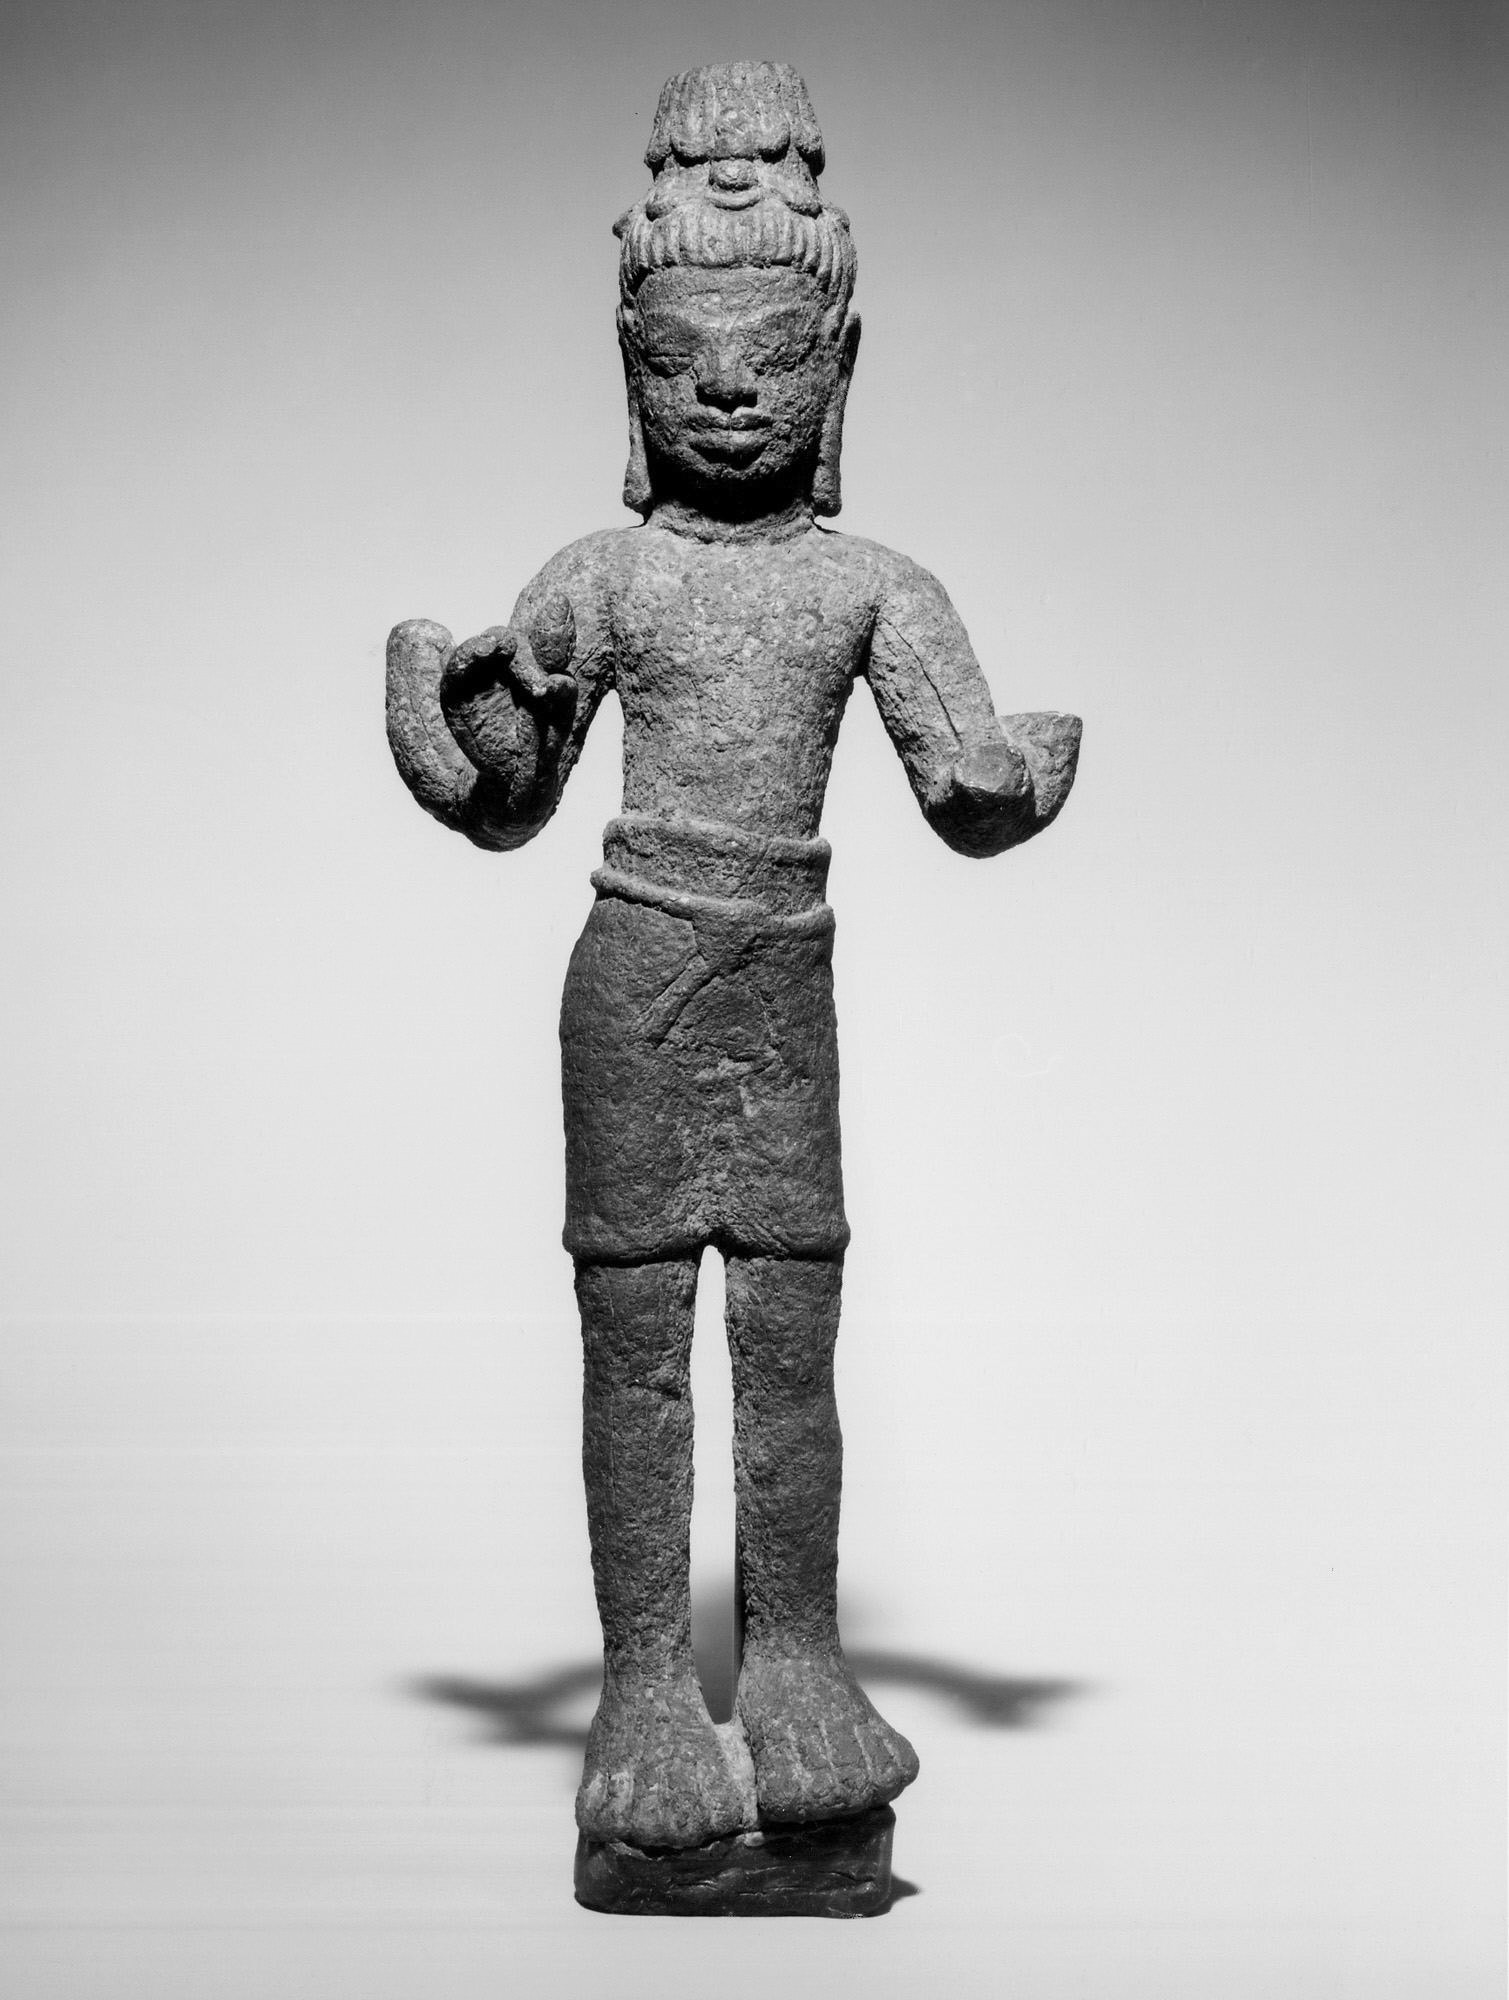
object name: figure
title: Standing Bodhisattva Maitreya, the Buddha of the Future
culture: plai bat ii temple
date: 801-1000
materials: bronze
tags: buddhism,bodhisattvas,maitreya